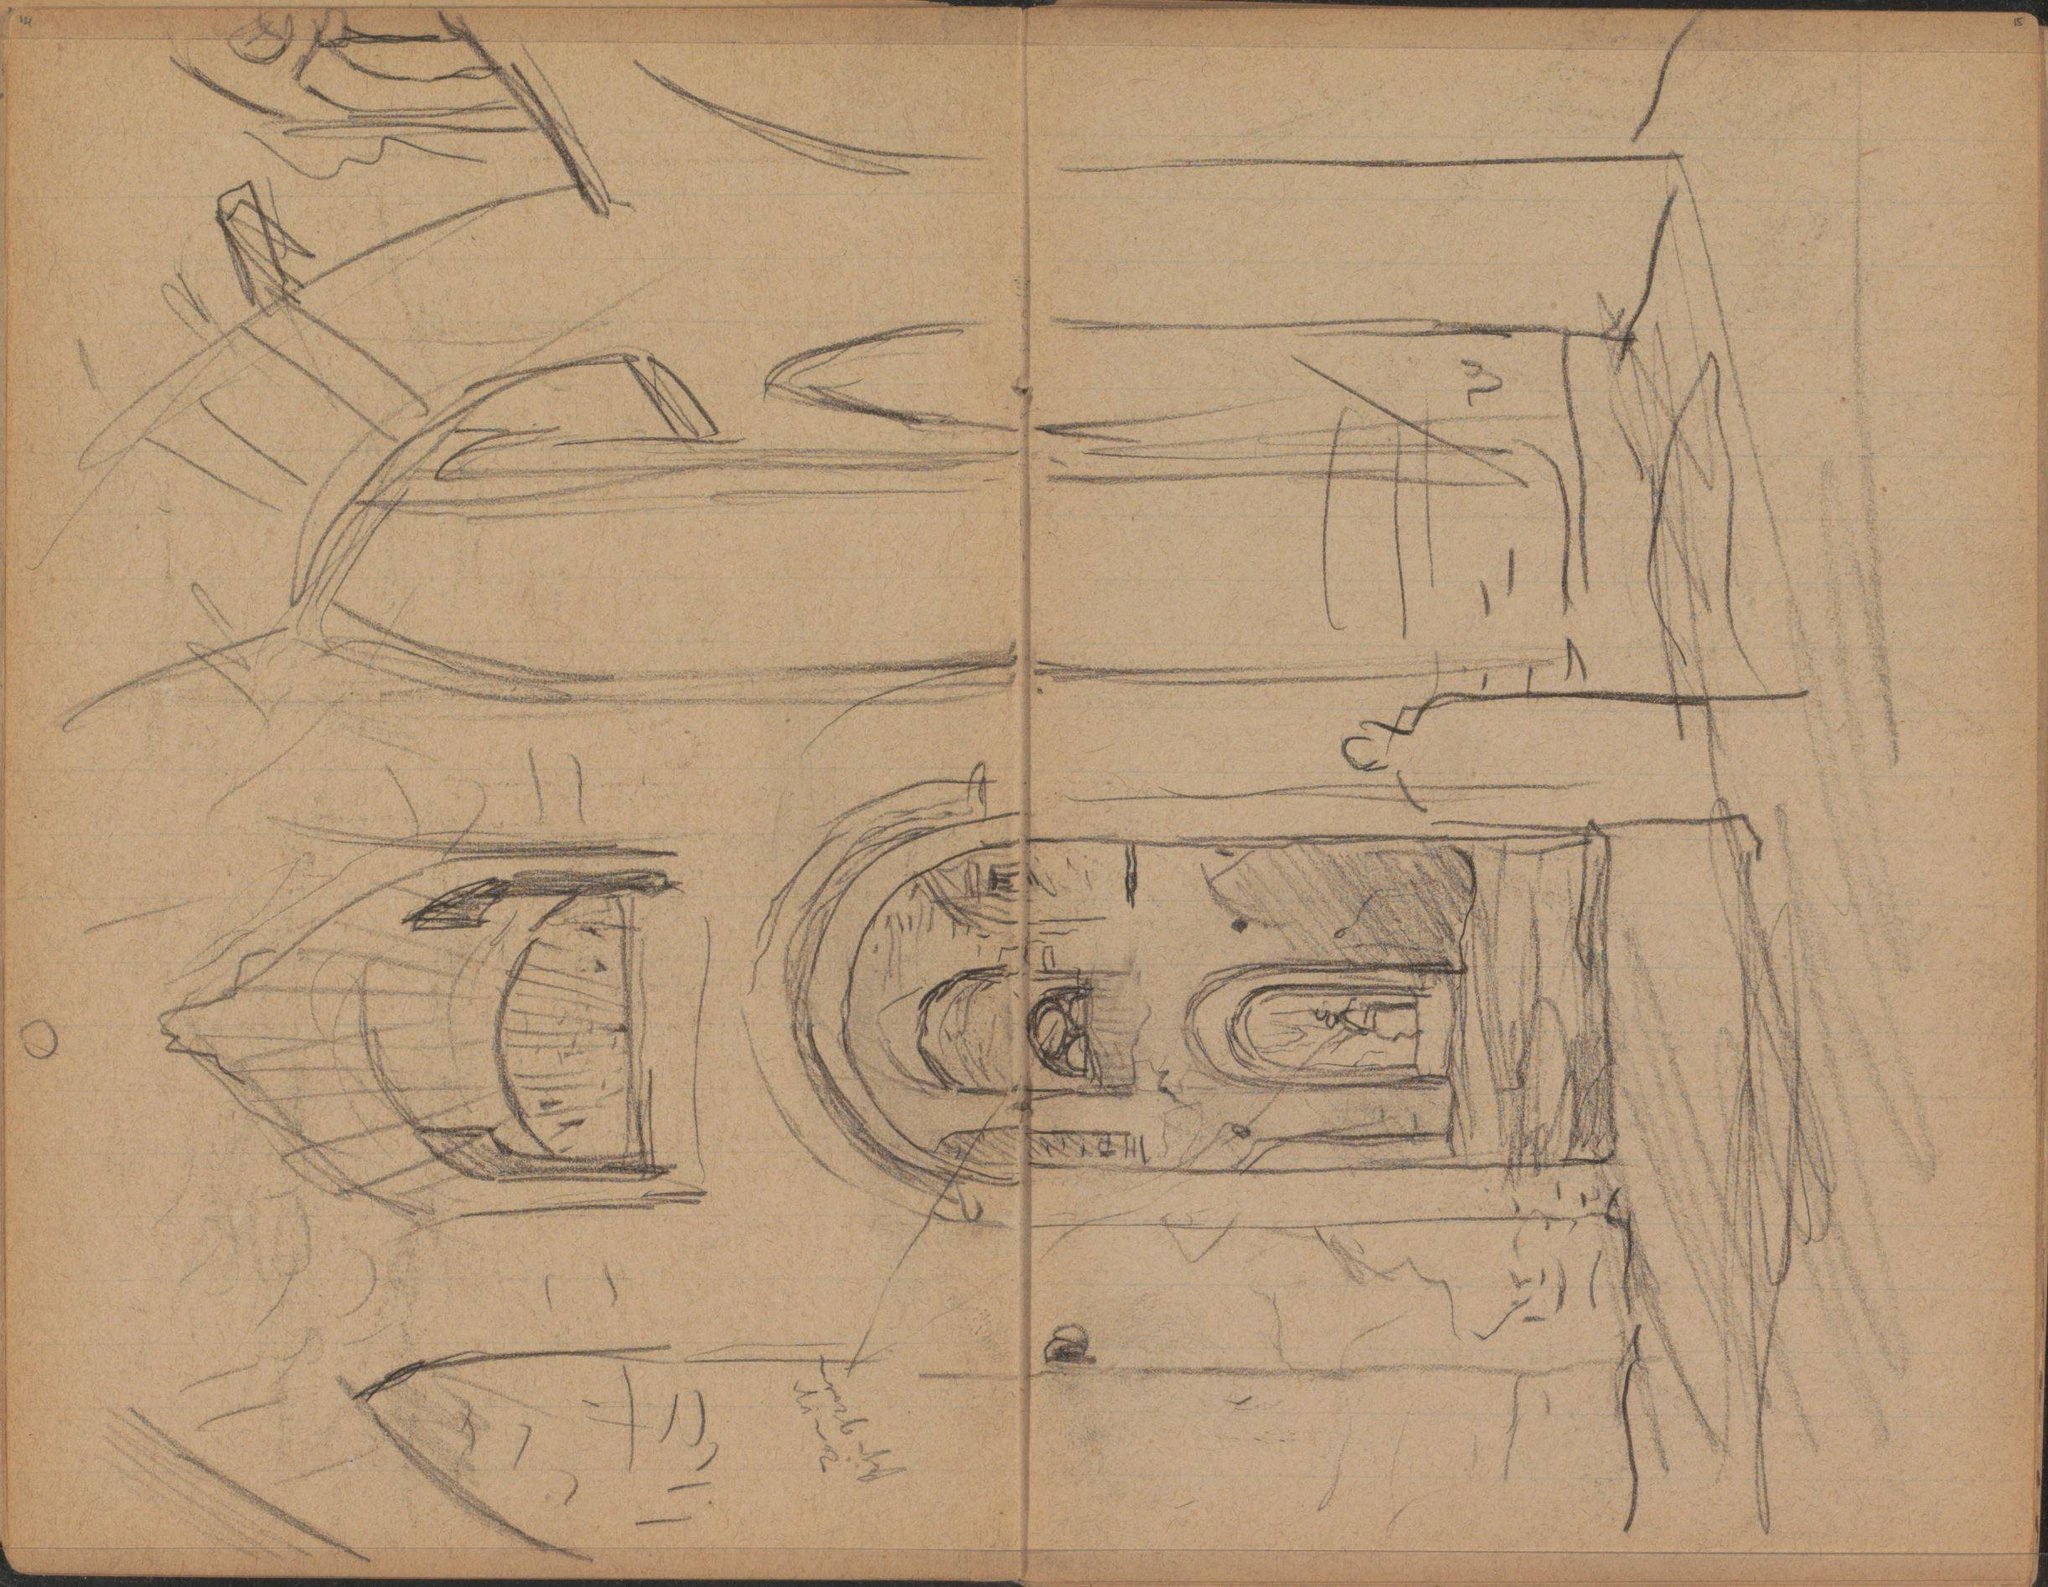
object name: sketchbook leaf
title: Figuur bij een poort naar een binnenplaats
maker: marius bauer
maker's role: draughtsman, print maker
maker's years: 1867-1932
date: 1896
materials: chalk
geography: russia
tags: standing figure, arch, archivolt ~ architecture, courtyard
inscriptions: kleurnotitie, handgeschreven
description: Pagina 14 en 15 uit een schetsboek met 50 bladen.